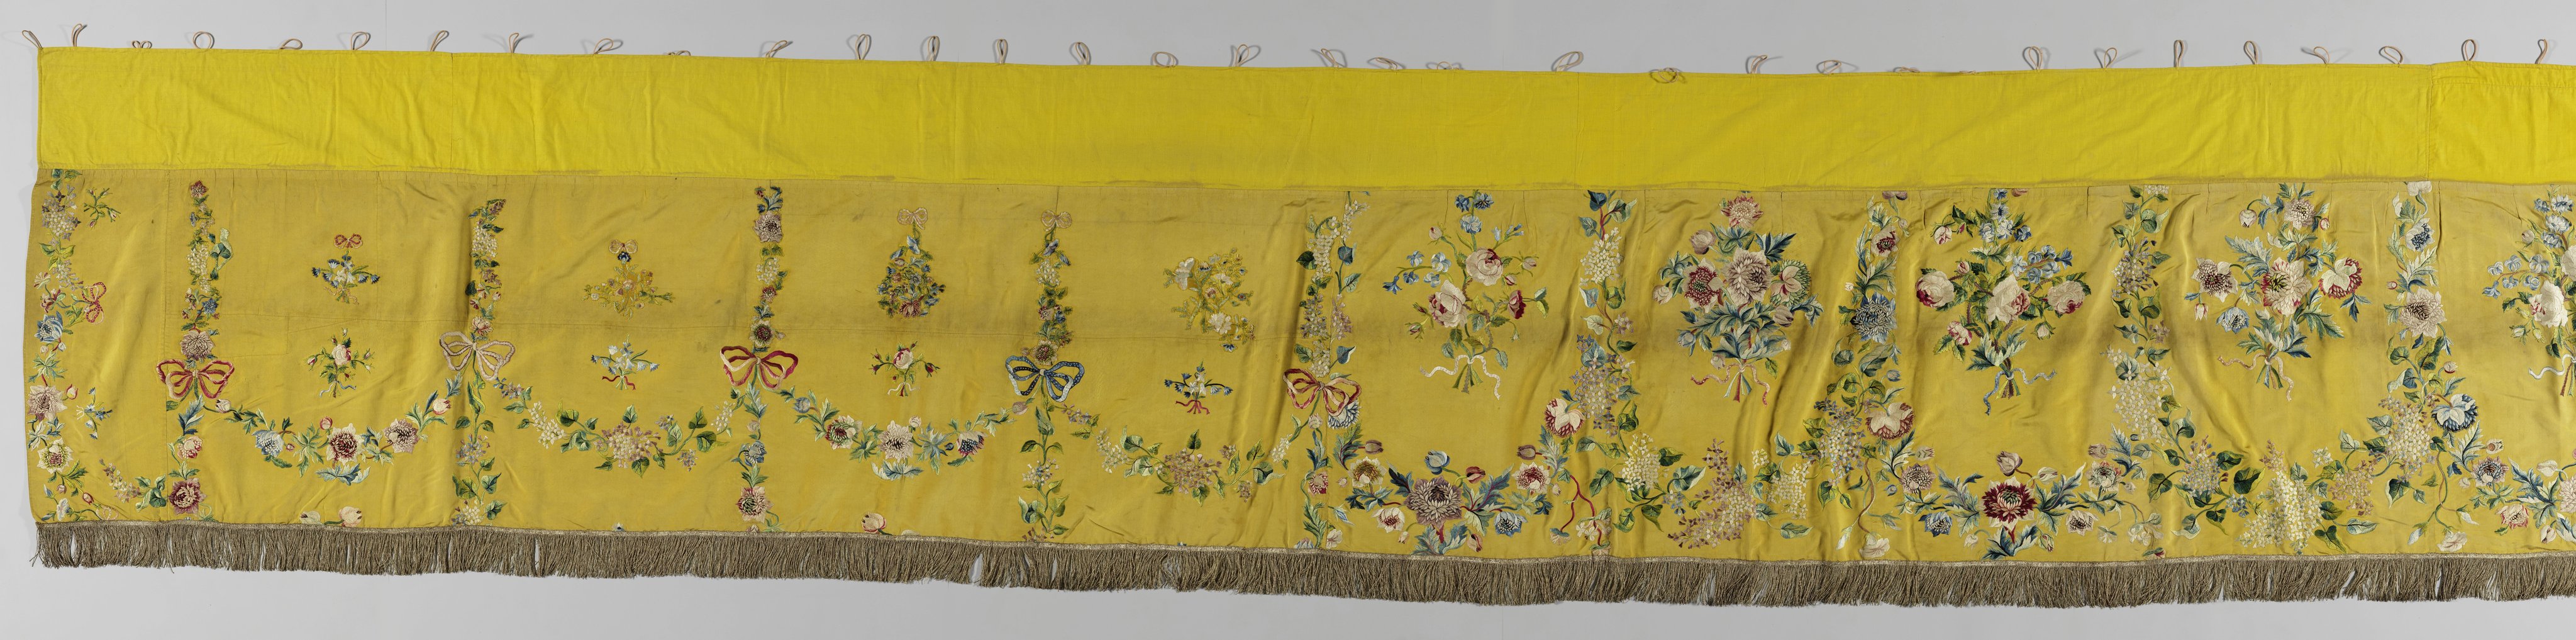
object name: communiebankkleed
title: Communiebankkleed met borduurwerk, van zijde op ripszijde.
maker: Anonymous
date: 1770-1780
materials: silk, thread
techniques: embroidered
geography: netherlands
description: Rechthoekig kleed met borduurwerk, een gele voering en zilveren franje. Het patroon heeft bloemslingers met seringen en papavers en door linten samengebonden boeketten van rozen en papavers.